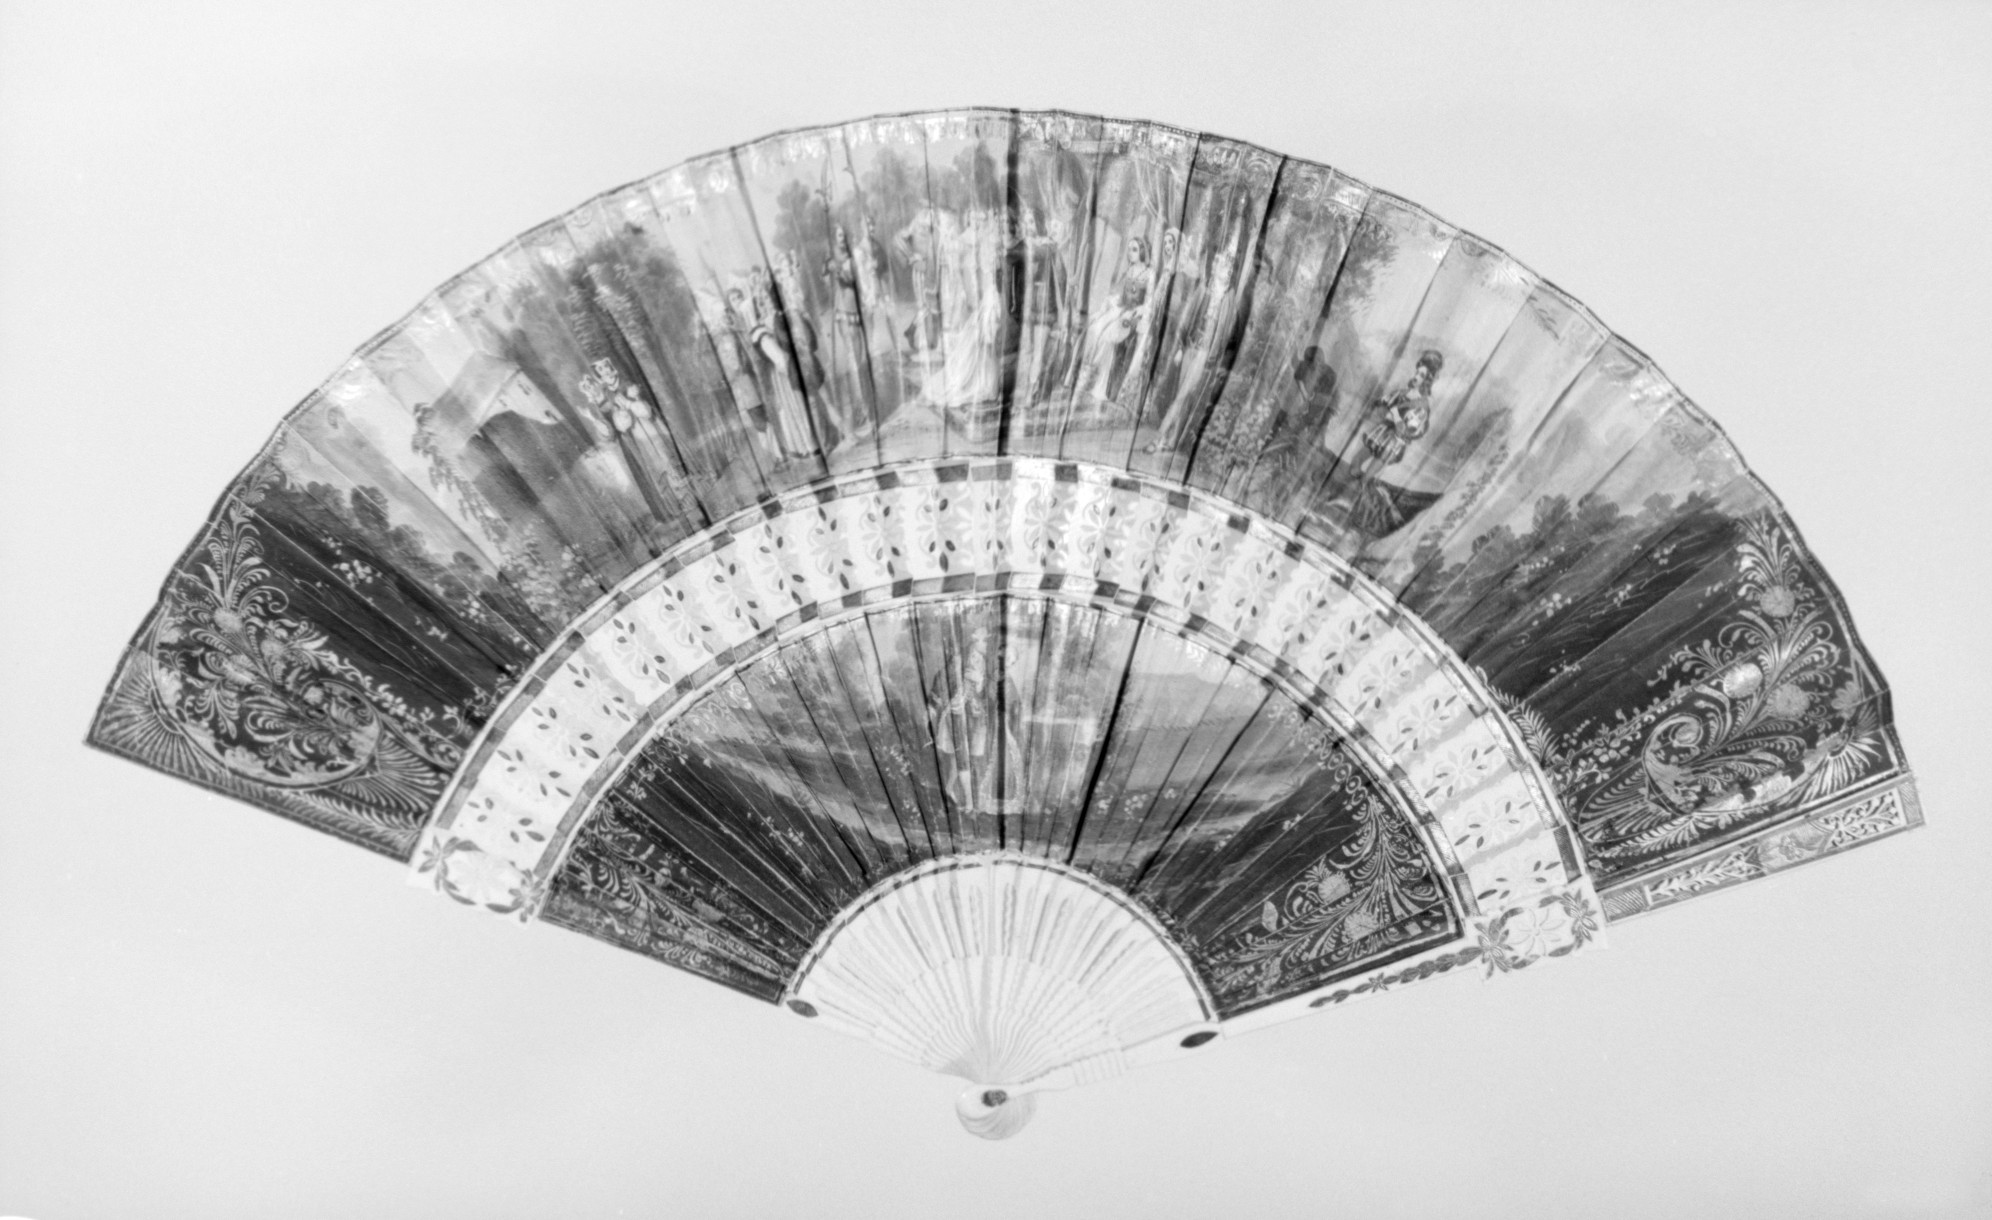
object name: fan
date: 1834-1866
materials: gilt, glass, gold, ivory, paint, paper, parchment, silver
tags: men,women